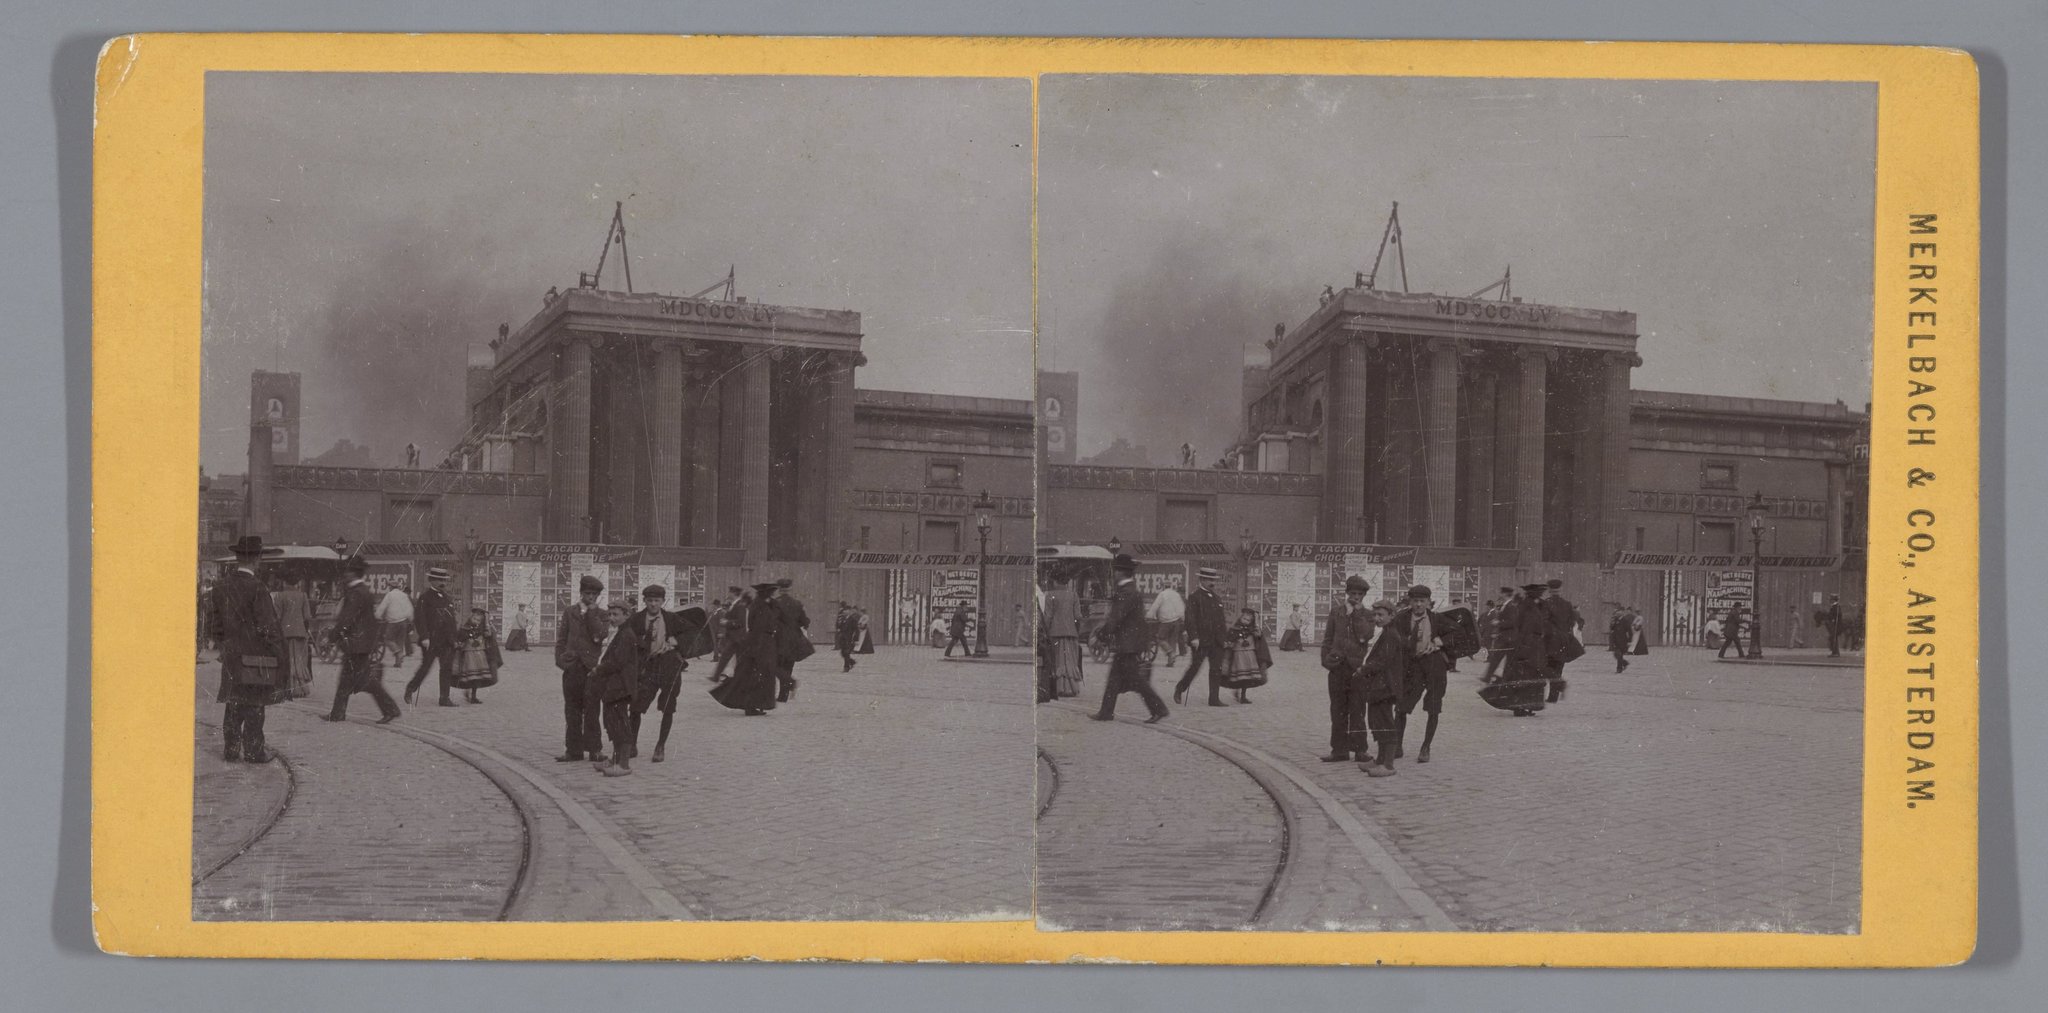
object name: stereograph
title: Beurs van Zocher tijdens de sloop, Amsterdam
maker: Anonymous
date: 1903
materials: paper, cardboard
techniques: gelatin silver print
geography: amsterdam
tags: stock exchange, stock-market, demolition of building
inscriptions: inscription: ‘Afbraak oude Beurs/ Volgens Oom Piet/ Komt de rook op d'achtergrond van dynamiet’